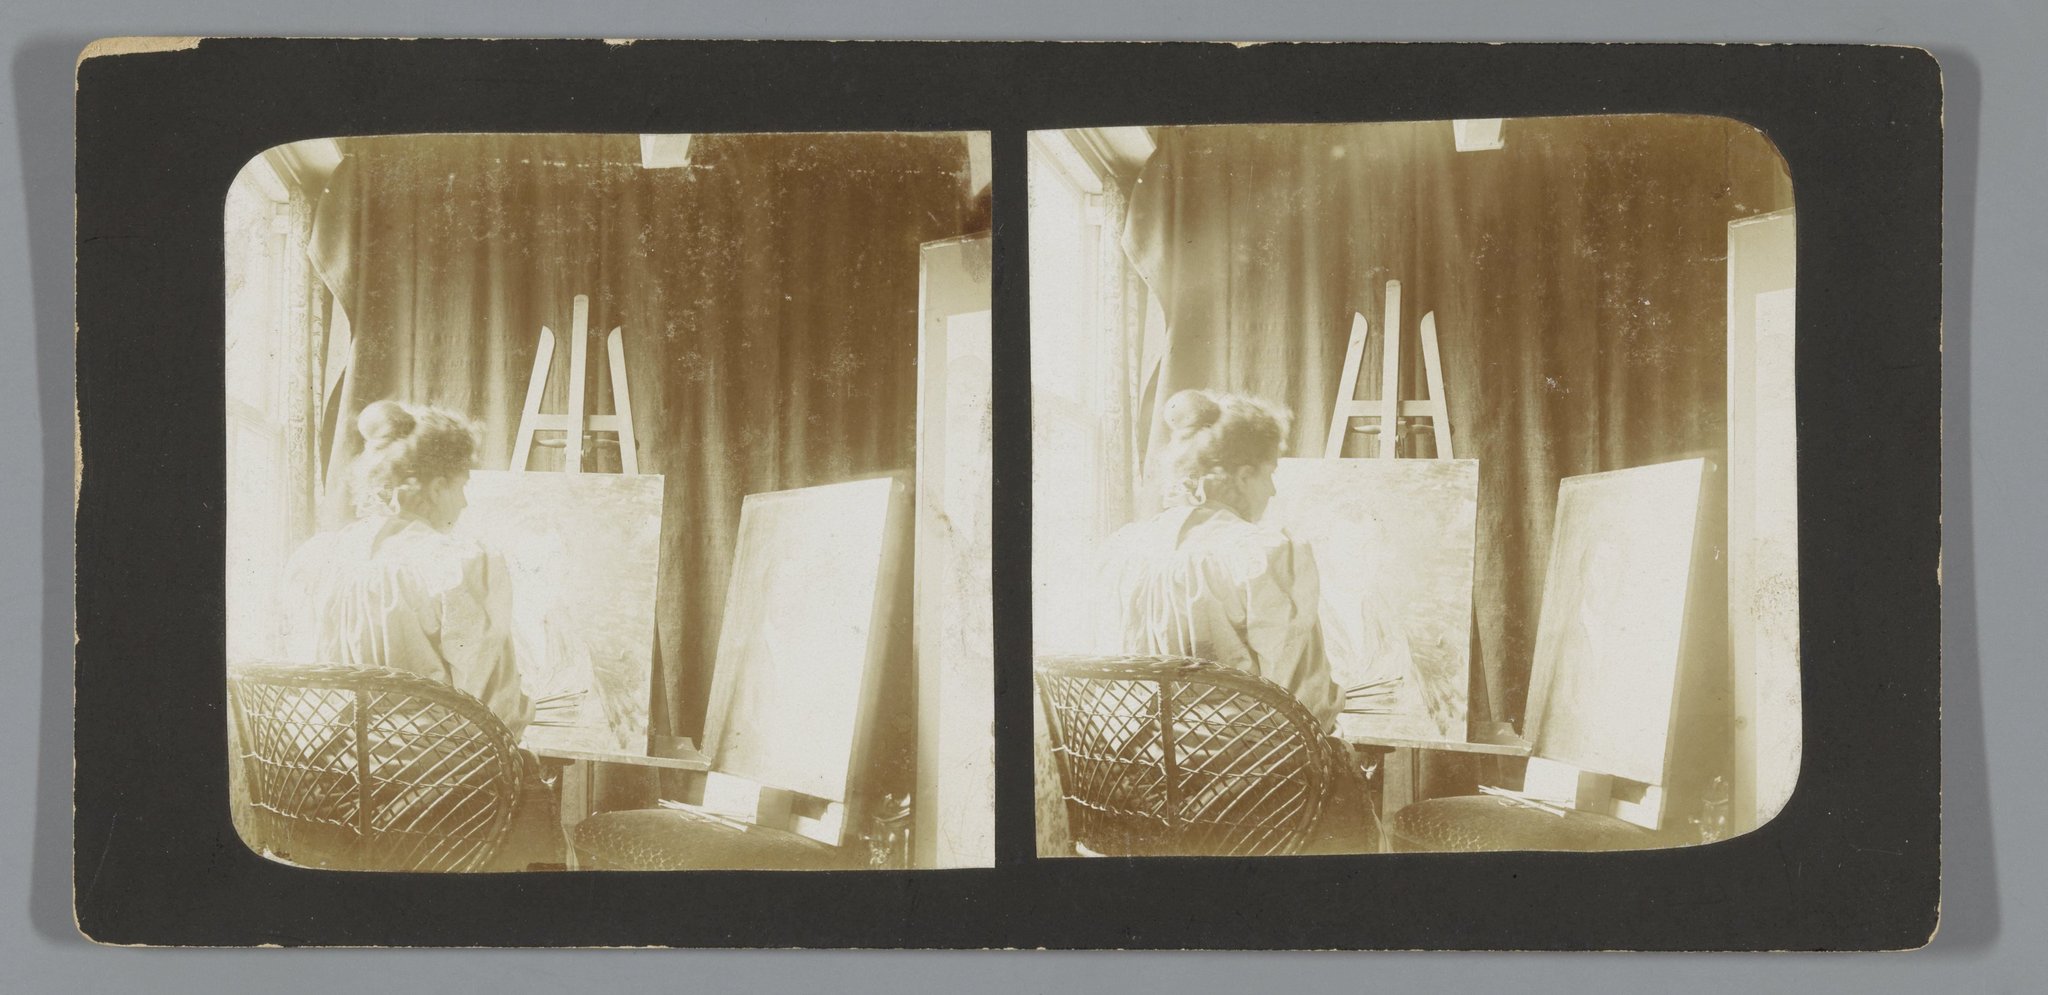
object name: stereograph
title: Cornelia Margaretha Scheltema Beduin achter een schildersezel in haar atelier, Singel 256, Amsterdam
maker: adrianus scheltema-beduin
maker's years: 1864-1944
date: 1899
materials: paper, cardboard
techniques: collodion silver print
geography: amsterdam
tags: easel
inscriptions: inscription: ‘Cornelia in haar Atelier boven./ Kamer van Johan./ 22 Oct 99.’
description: Cornelia Margaretha Scheltema Beduin was de zus van de fotograaf.